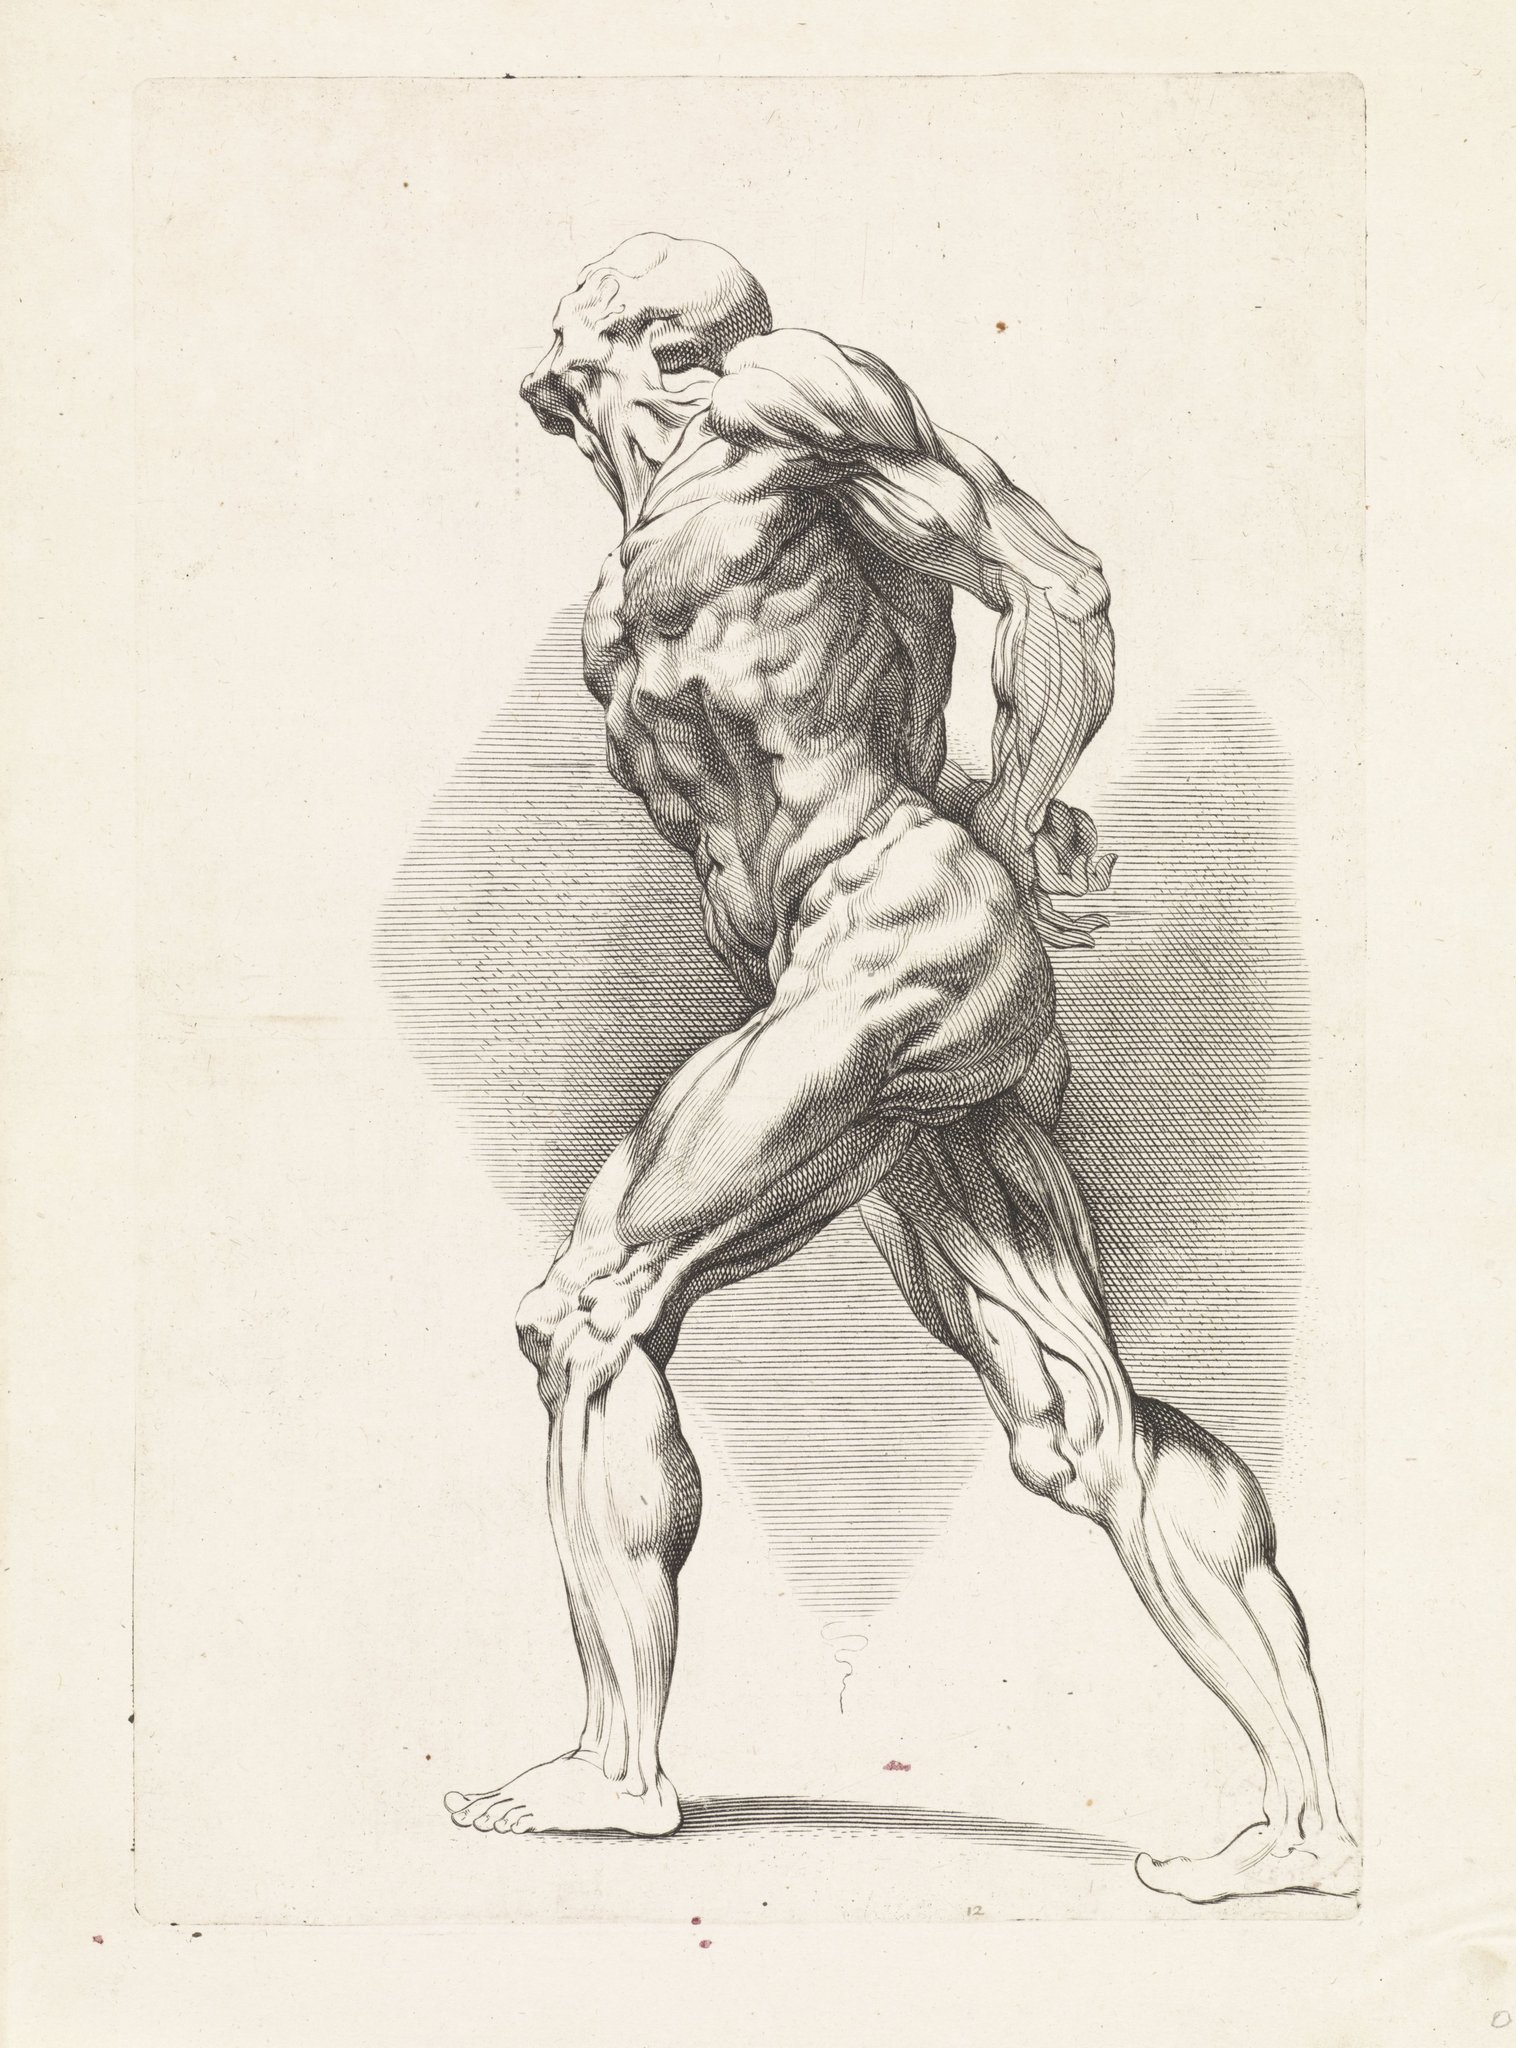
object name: print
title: Het tekenboek van Peter Paul Rubens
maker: paulus pontius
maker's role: draughtsman, print maker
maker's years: 1603-1658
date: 1616-1657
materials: paper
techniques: engraving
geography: antwerp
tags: parts of the human body (skeleton excepted)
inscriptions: collector's mark: Lugt 240, number: ‘12’